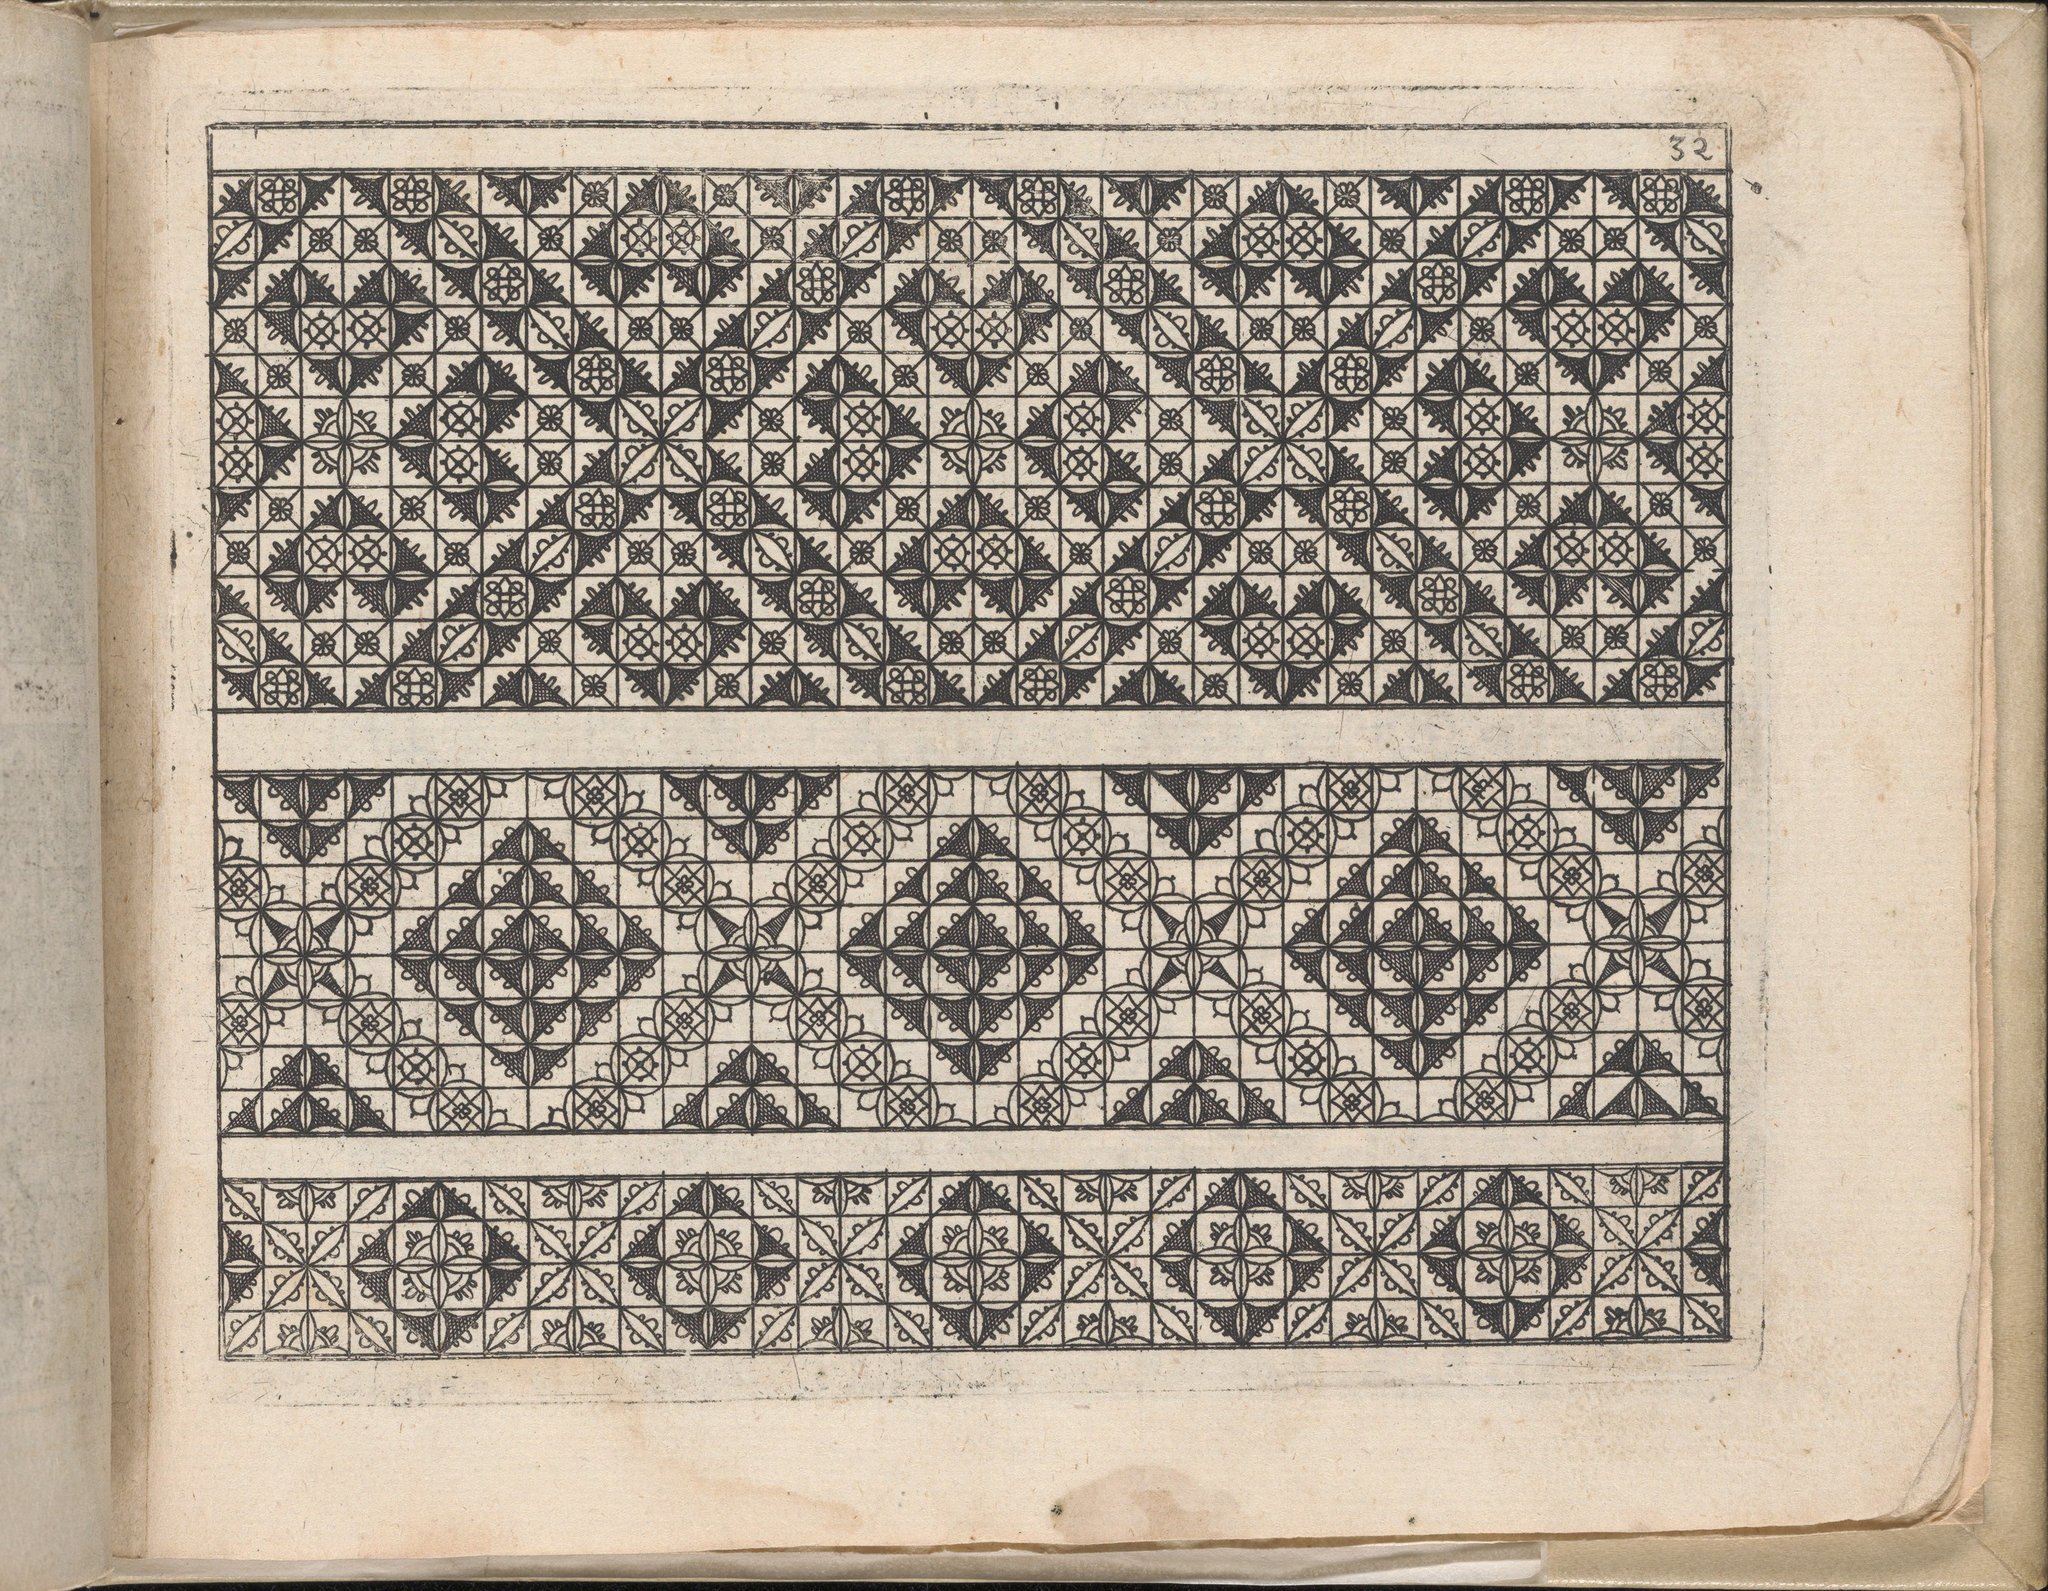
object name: book print ornament architecture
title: Schön Neues Modelbuch (Page 37 recto)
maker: johann sibmacher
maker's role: designer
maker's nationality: german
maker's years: 1590-1611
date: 1597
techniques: etching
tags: ornament